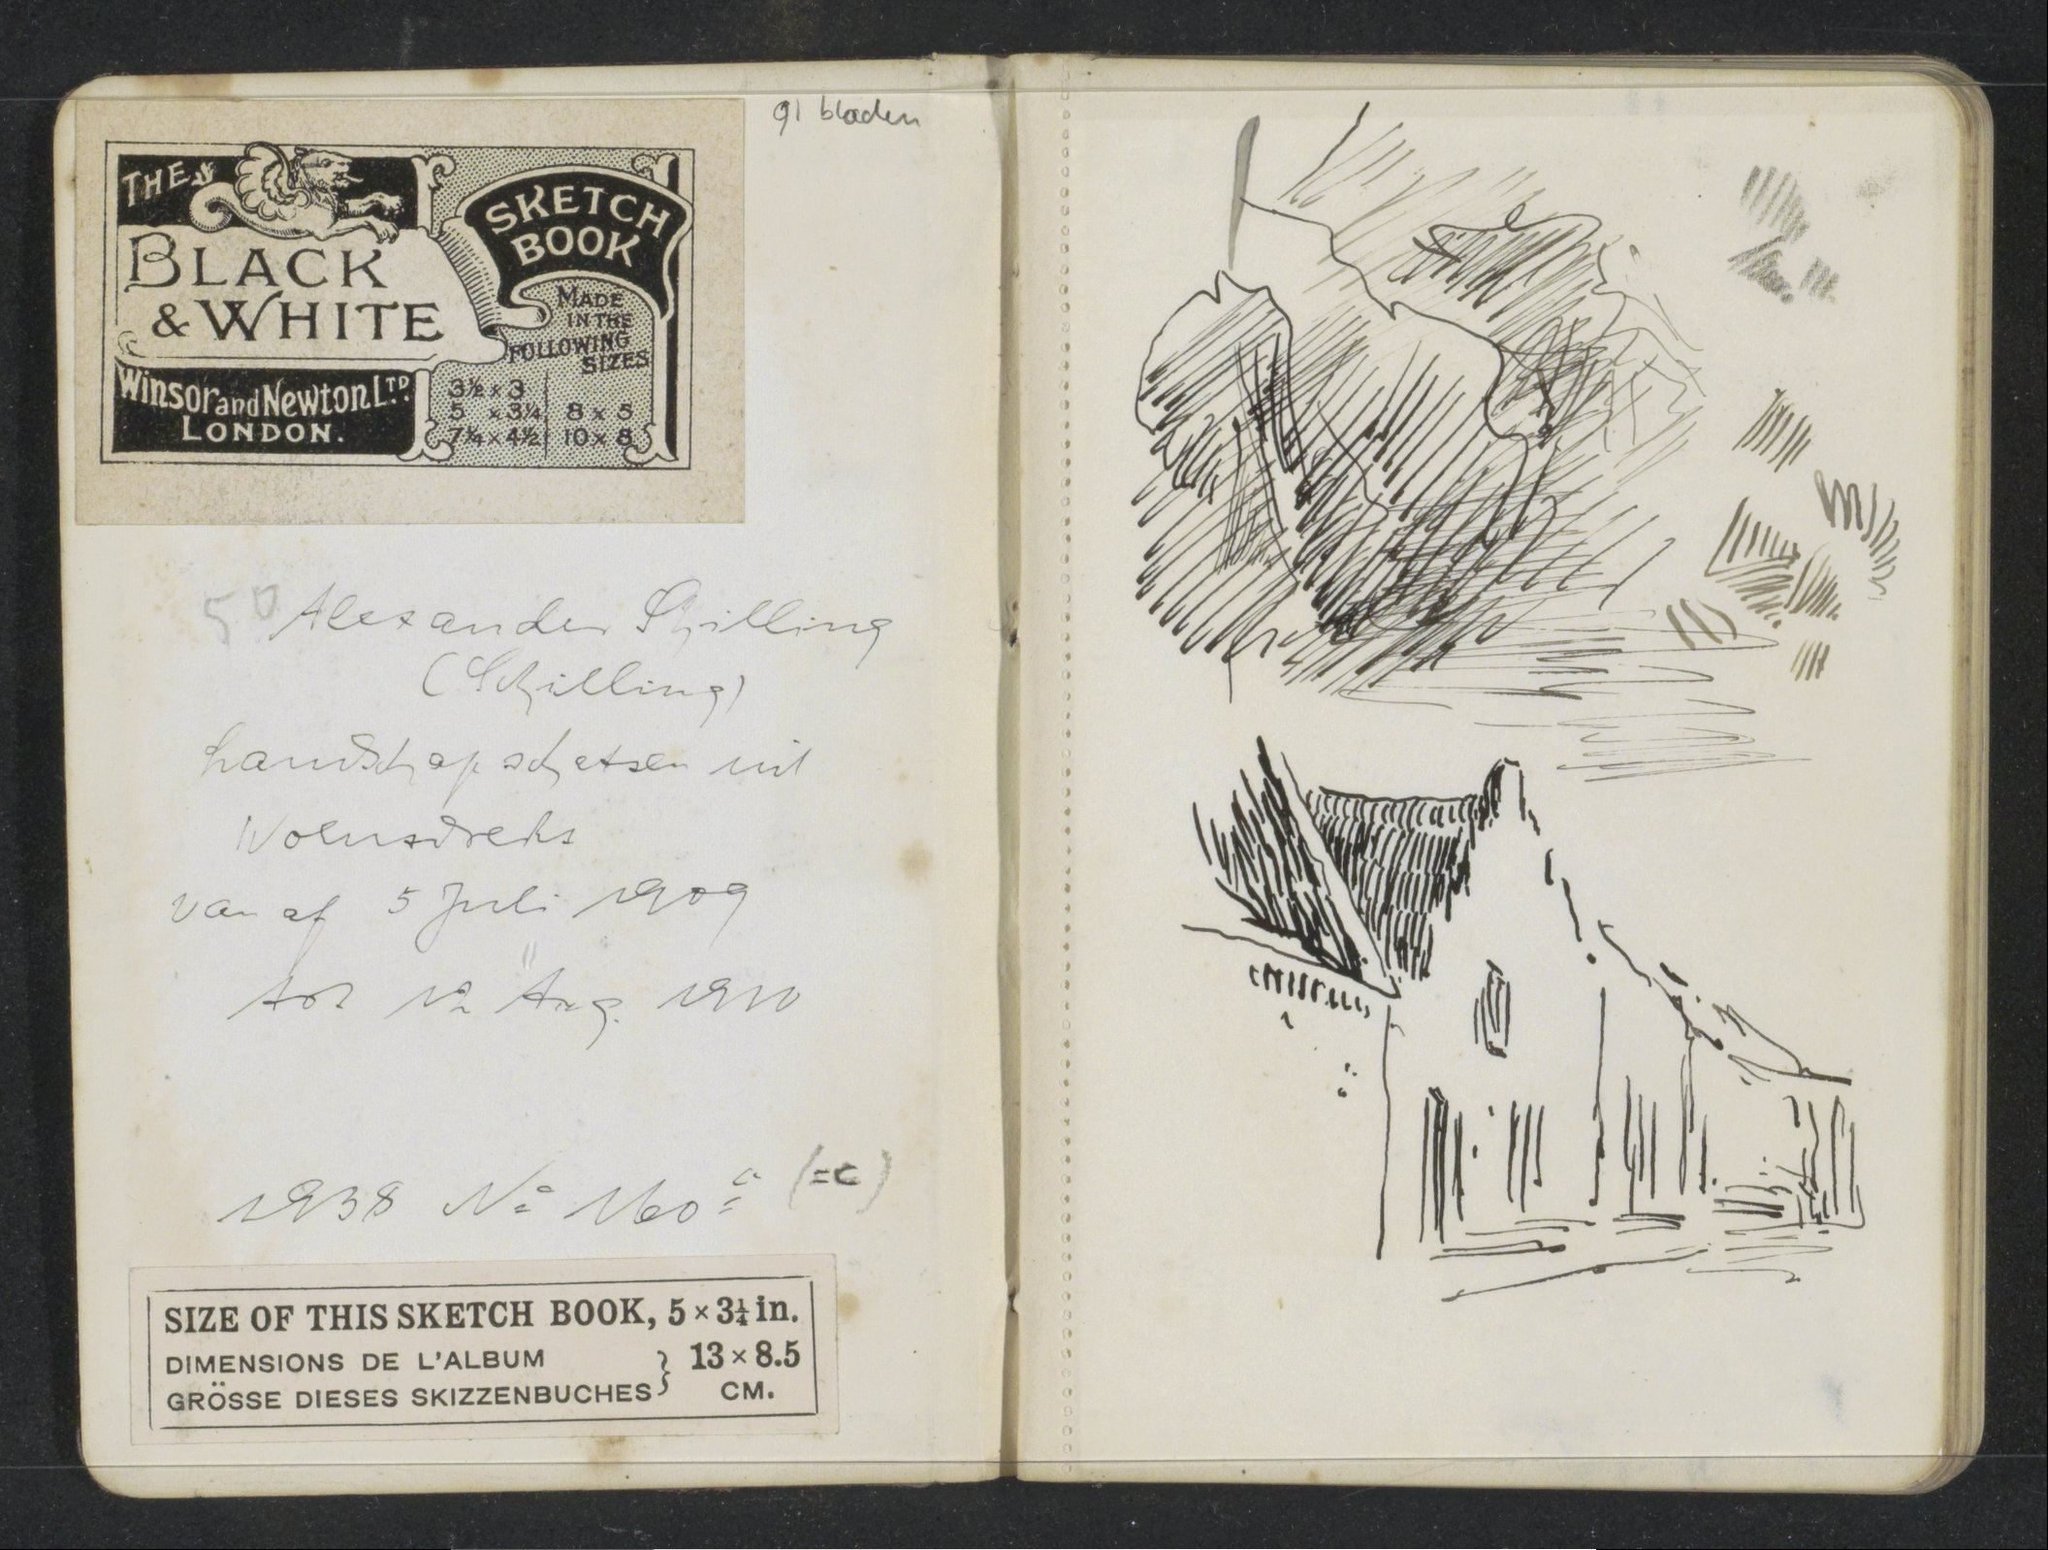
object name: sketchbook leaf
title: Bomen en een straat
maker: alexander shilling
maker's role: draughtsman, print maker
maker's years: 1859-1937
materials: ink, paper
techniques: pen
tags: trees, village street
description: Blad 1 recto uit een schetsboek met 91 bladen.